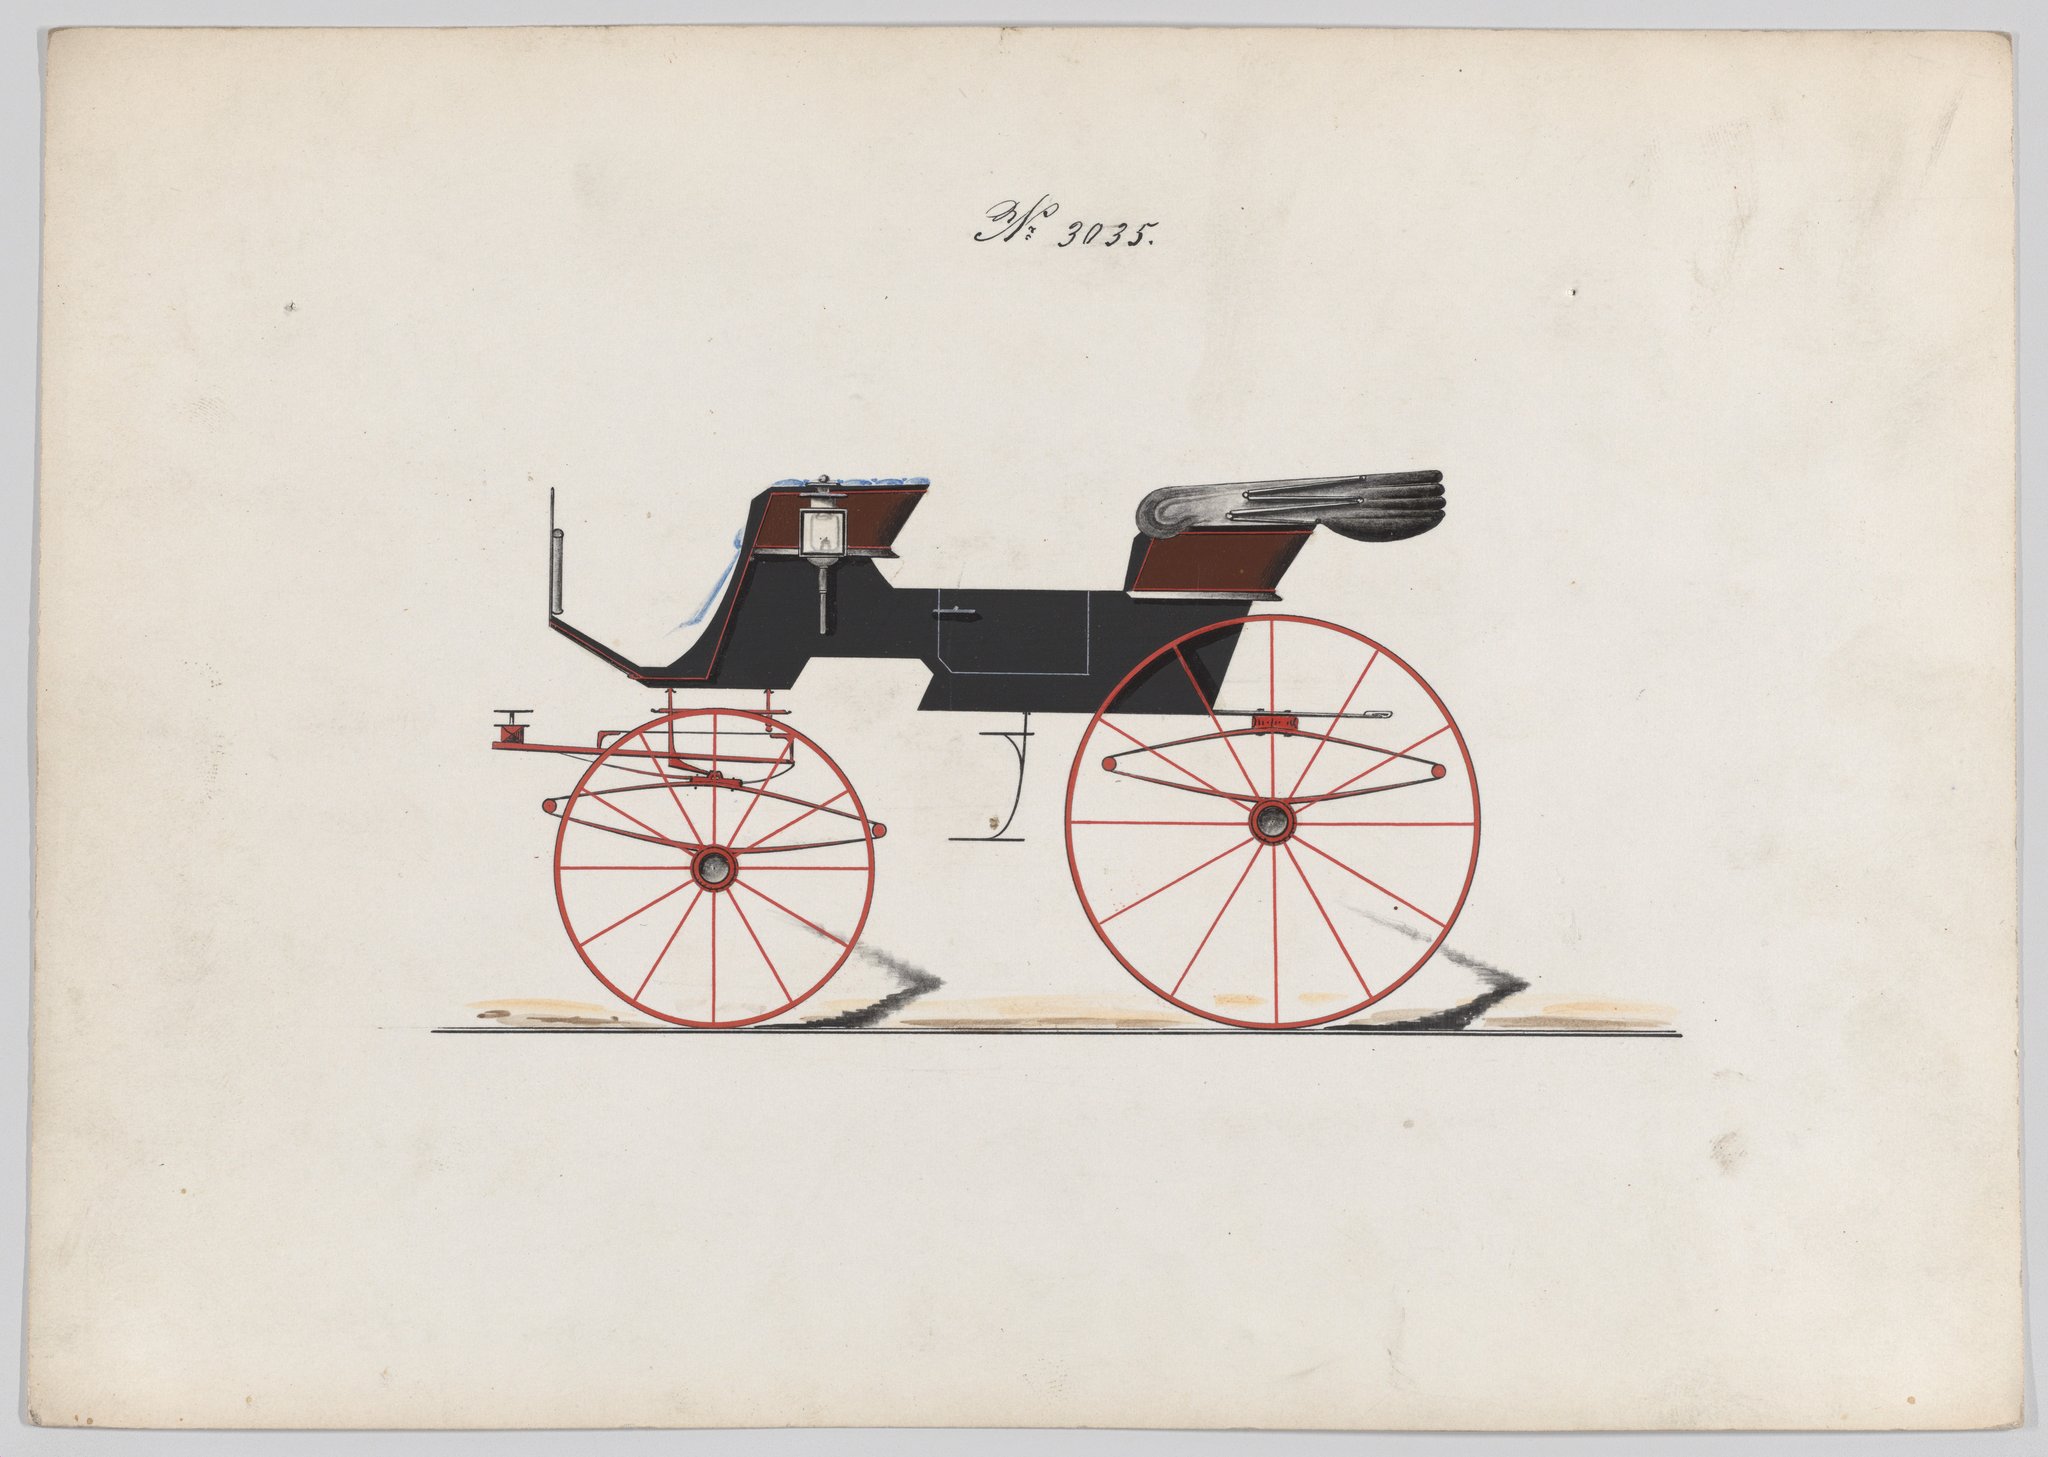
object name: drawing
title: Design for 2 seat Phaeton, no. 3035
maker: brewster & co.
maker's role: manufacturer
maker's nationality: american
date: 1874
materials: gouache, gum arabic, ink, watercolor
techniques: pen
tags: carriages